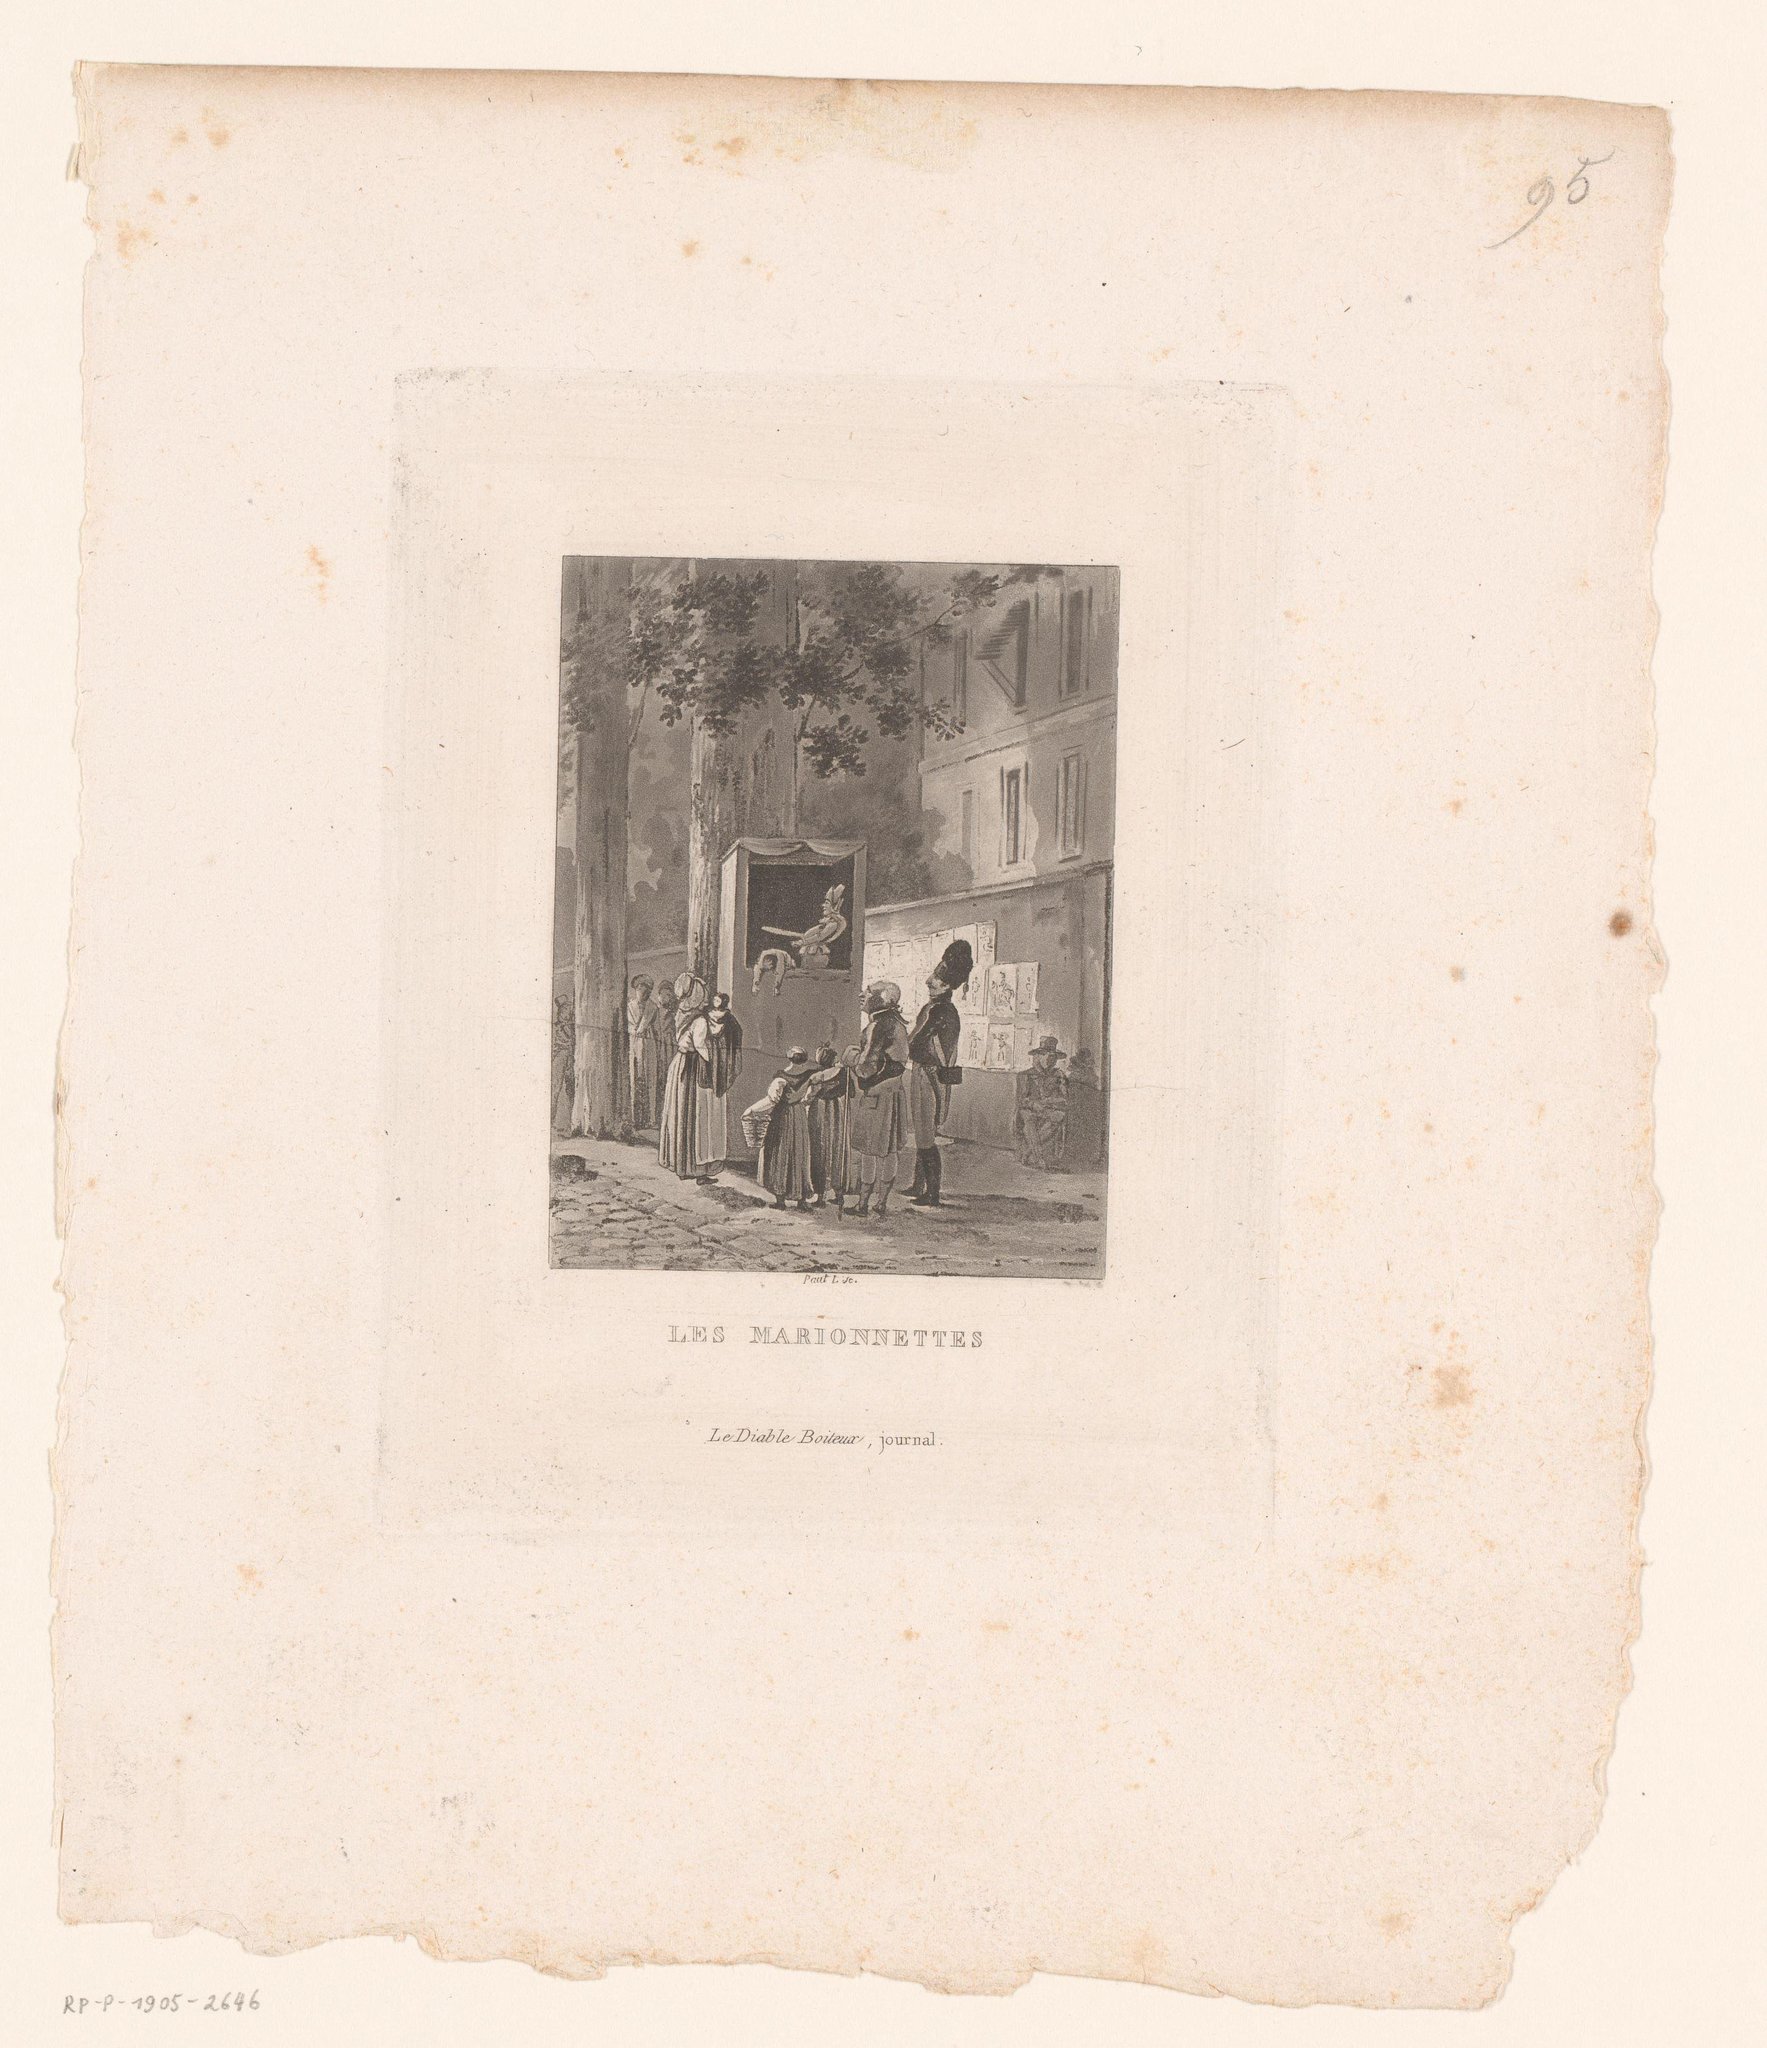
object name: print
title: Les marionnettes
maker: paul legrand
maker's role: print maker, publisher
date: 1824-1848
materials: paper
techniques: aquatint, etching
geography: france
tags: puppet and marionette show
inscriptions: collector's mark: Lugt 2228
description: Deze prent is vermoedelijk gepubliceerd in een tijdschrift met de naam 'Le diable boiteux' of is een verwijzing naar het gelijknamige ballet, opera of boek.